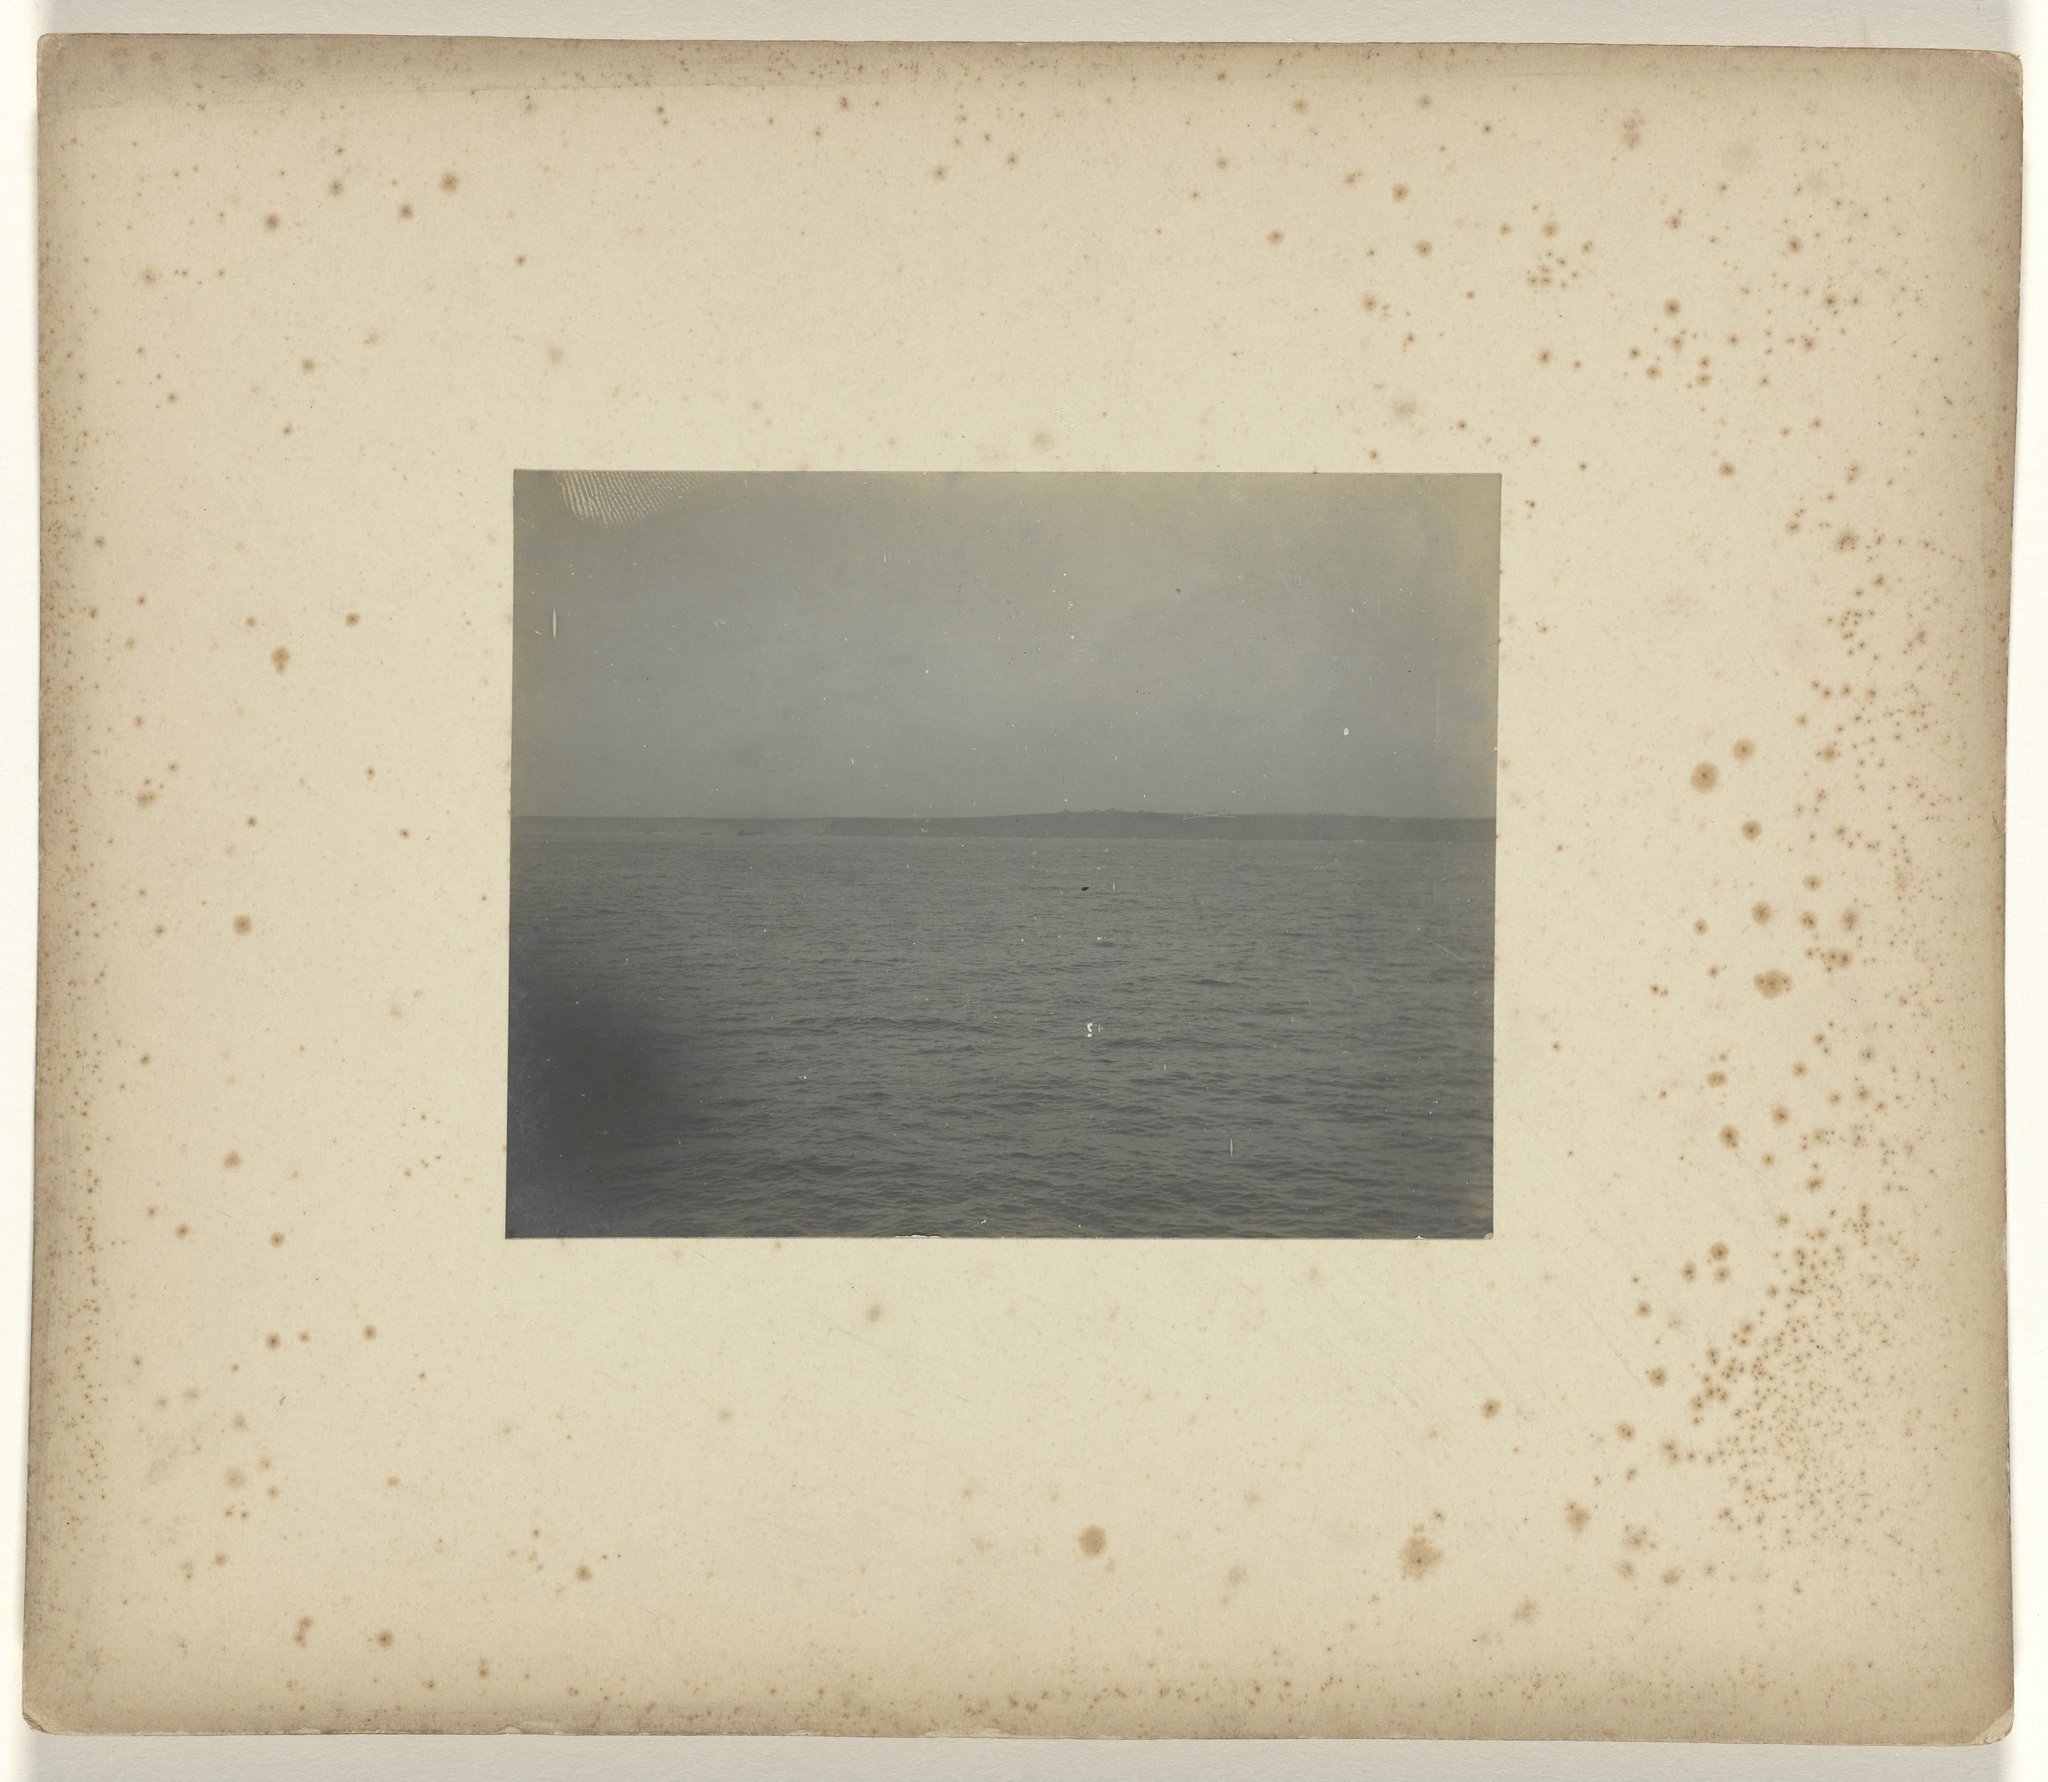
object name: photograph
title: Gezicht over een meer of zee tijdens de wereldtentoonstelling in St. Louis (Louisiana Purchase Exposition), 1904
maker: Anonymous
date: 1904-1905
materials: cardboard, paper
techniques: gelatin silver print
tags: missouri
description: Gezicht over een meer of zee tijdens de wereldtentoonstelling in St. Louis (Louisiana Purchase Exposition), 1904.